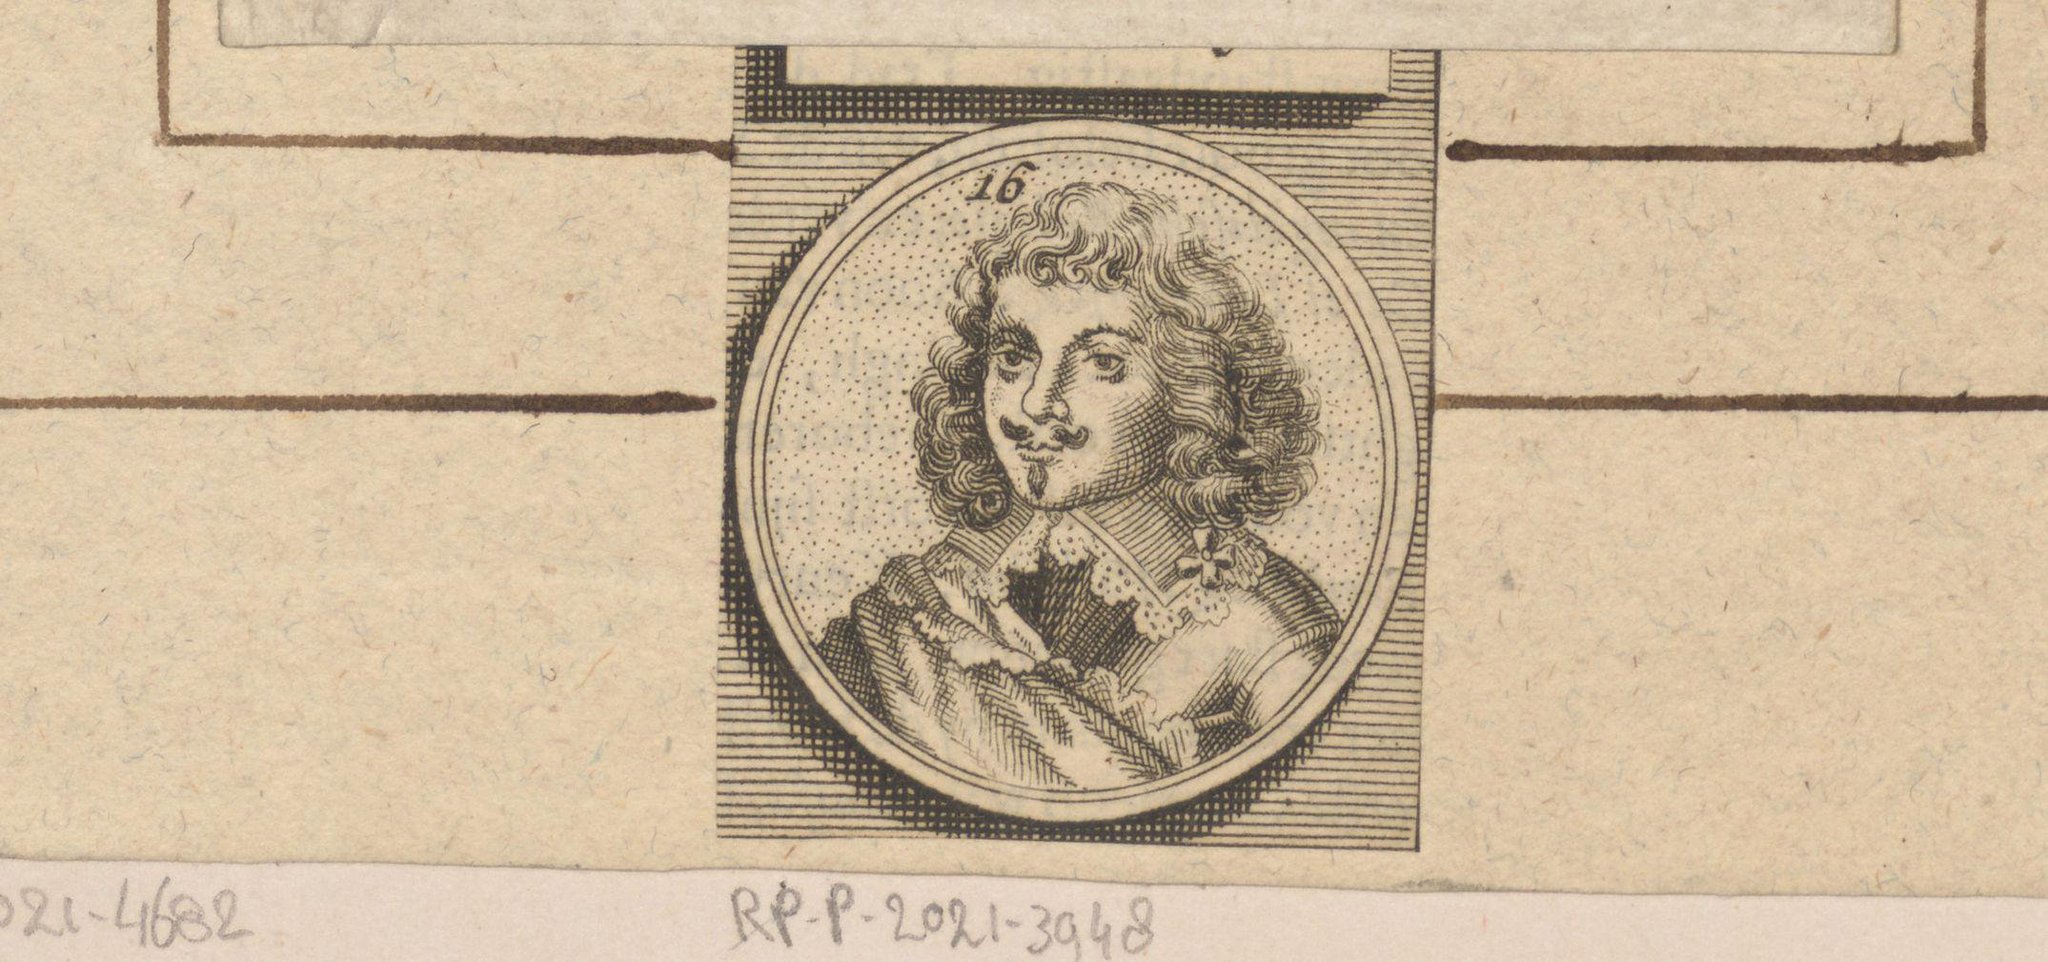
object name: print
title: Portret van Odoardo Farnese, hertog van Parma en Piacenza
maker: pieter van der aa (i)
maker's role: printer, publisher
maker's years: 1659-1733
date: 1698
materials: paper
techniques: engraving, etching, letterpress printing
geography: leiden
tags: historical persons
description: De prent maakt onderdeel uit van een grotere prent met 24 portretten die later verknipt is. Prent uit: Gottfried, Johan Ludwig en Simon de Vries. Historische kronyck: vervattende een nauwkeurige en volkomene beschrijvingh der aldergedenck waerdiste geschiedenissen des weerelds (...). Leiden: Pieter van der Aa, 1698, dl. 1. Prent voor het eerst gebruikt in hetzelfde boek uitgegeven in Amsterdam door weduwe Joannes Brouwer en Jacobus van Meurs in 1660. Prent mogelijk ook gebruikt in latere edities.